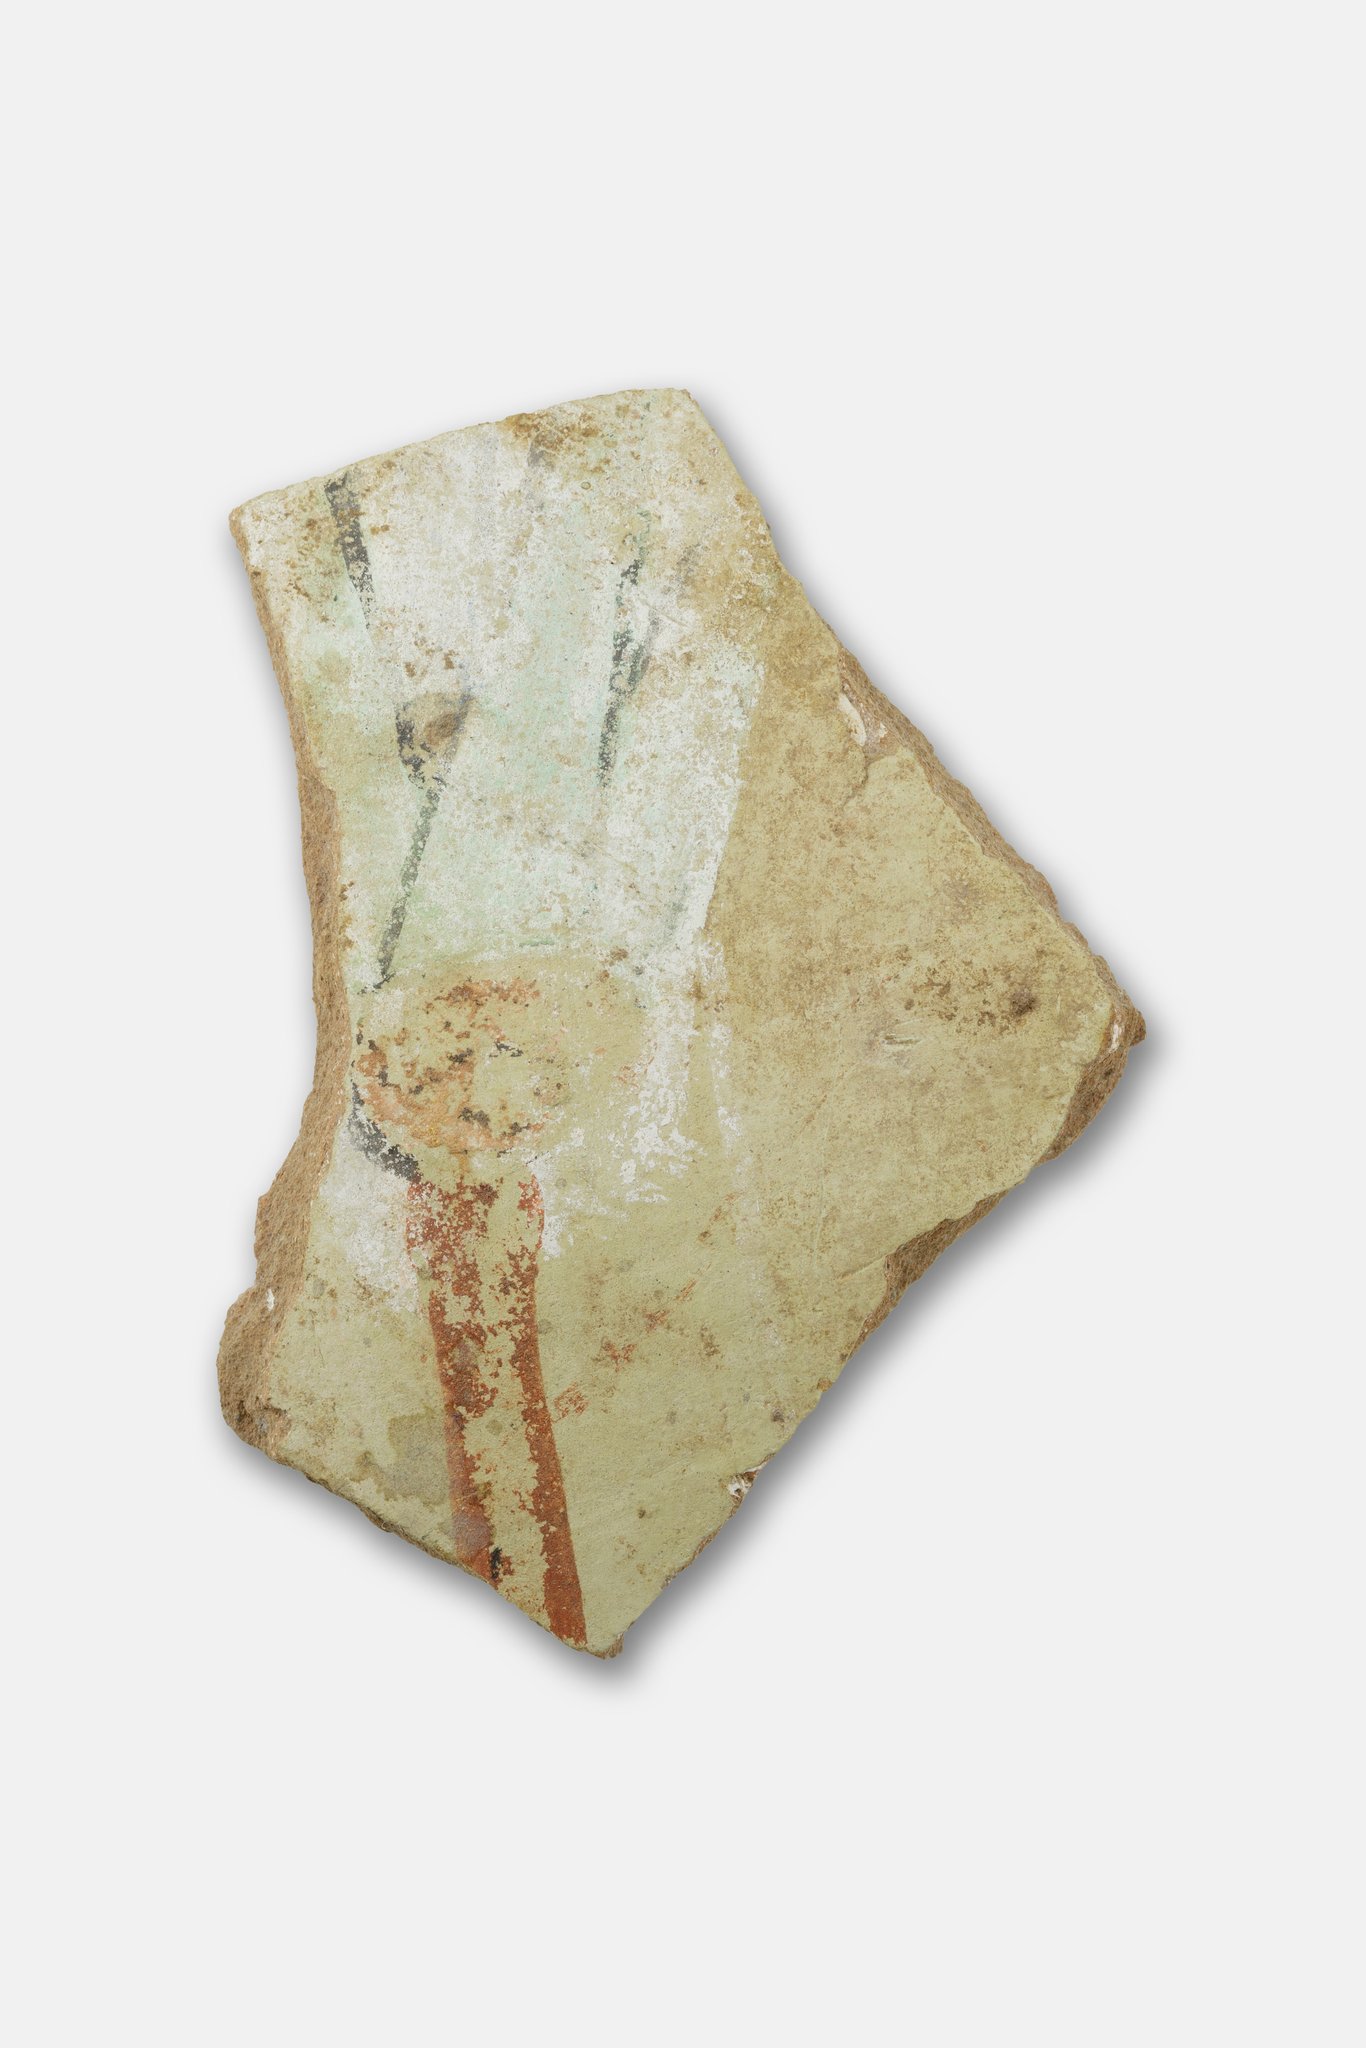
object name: jar fragment, malqata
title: Decorated jar fragment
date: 1390-1352 BCE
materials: ink, paint, pottery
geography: egypt